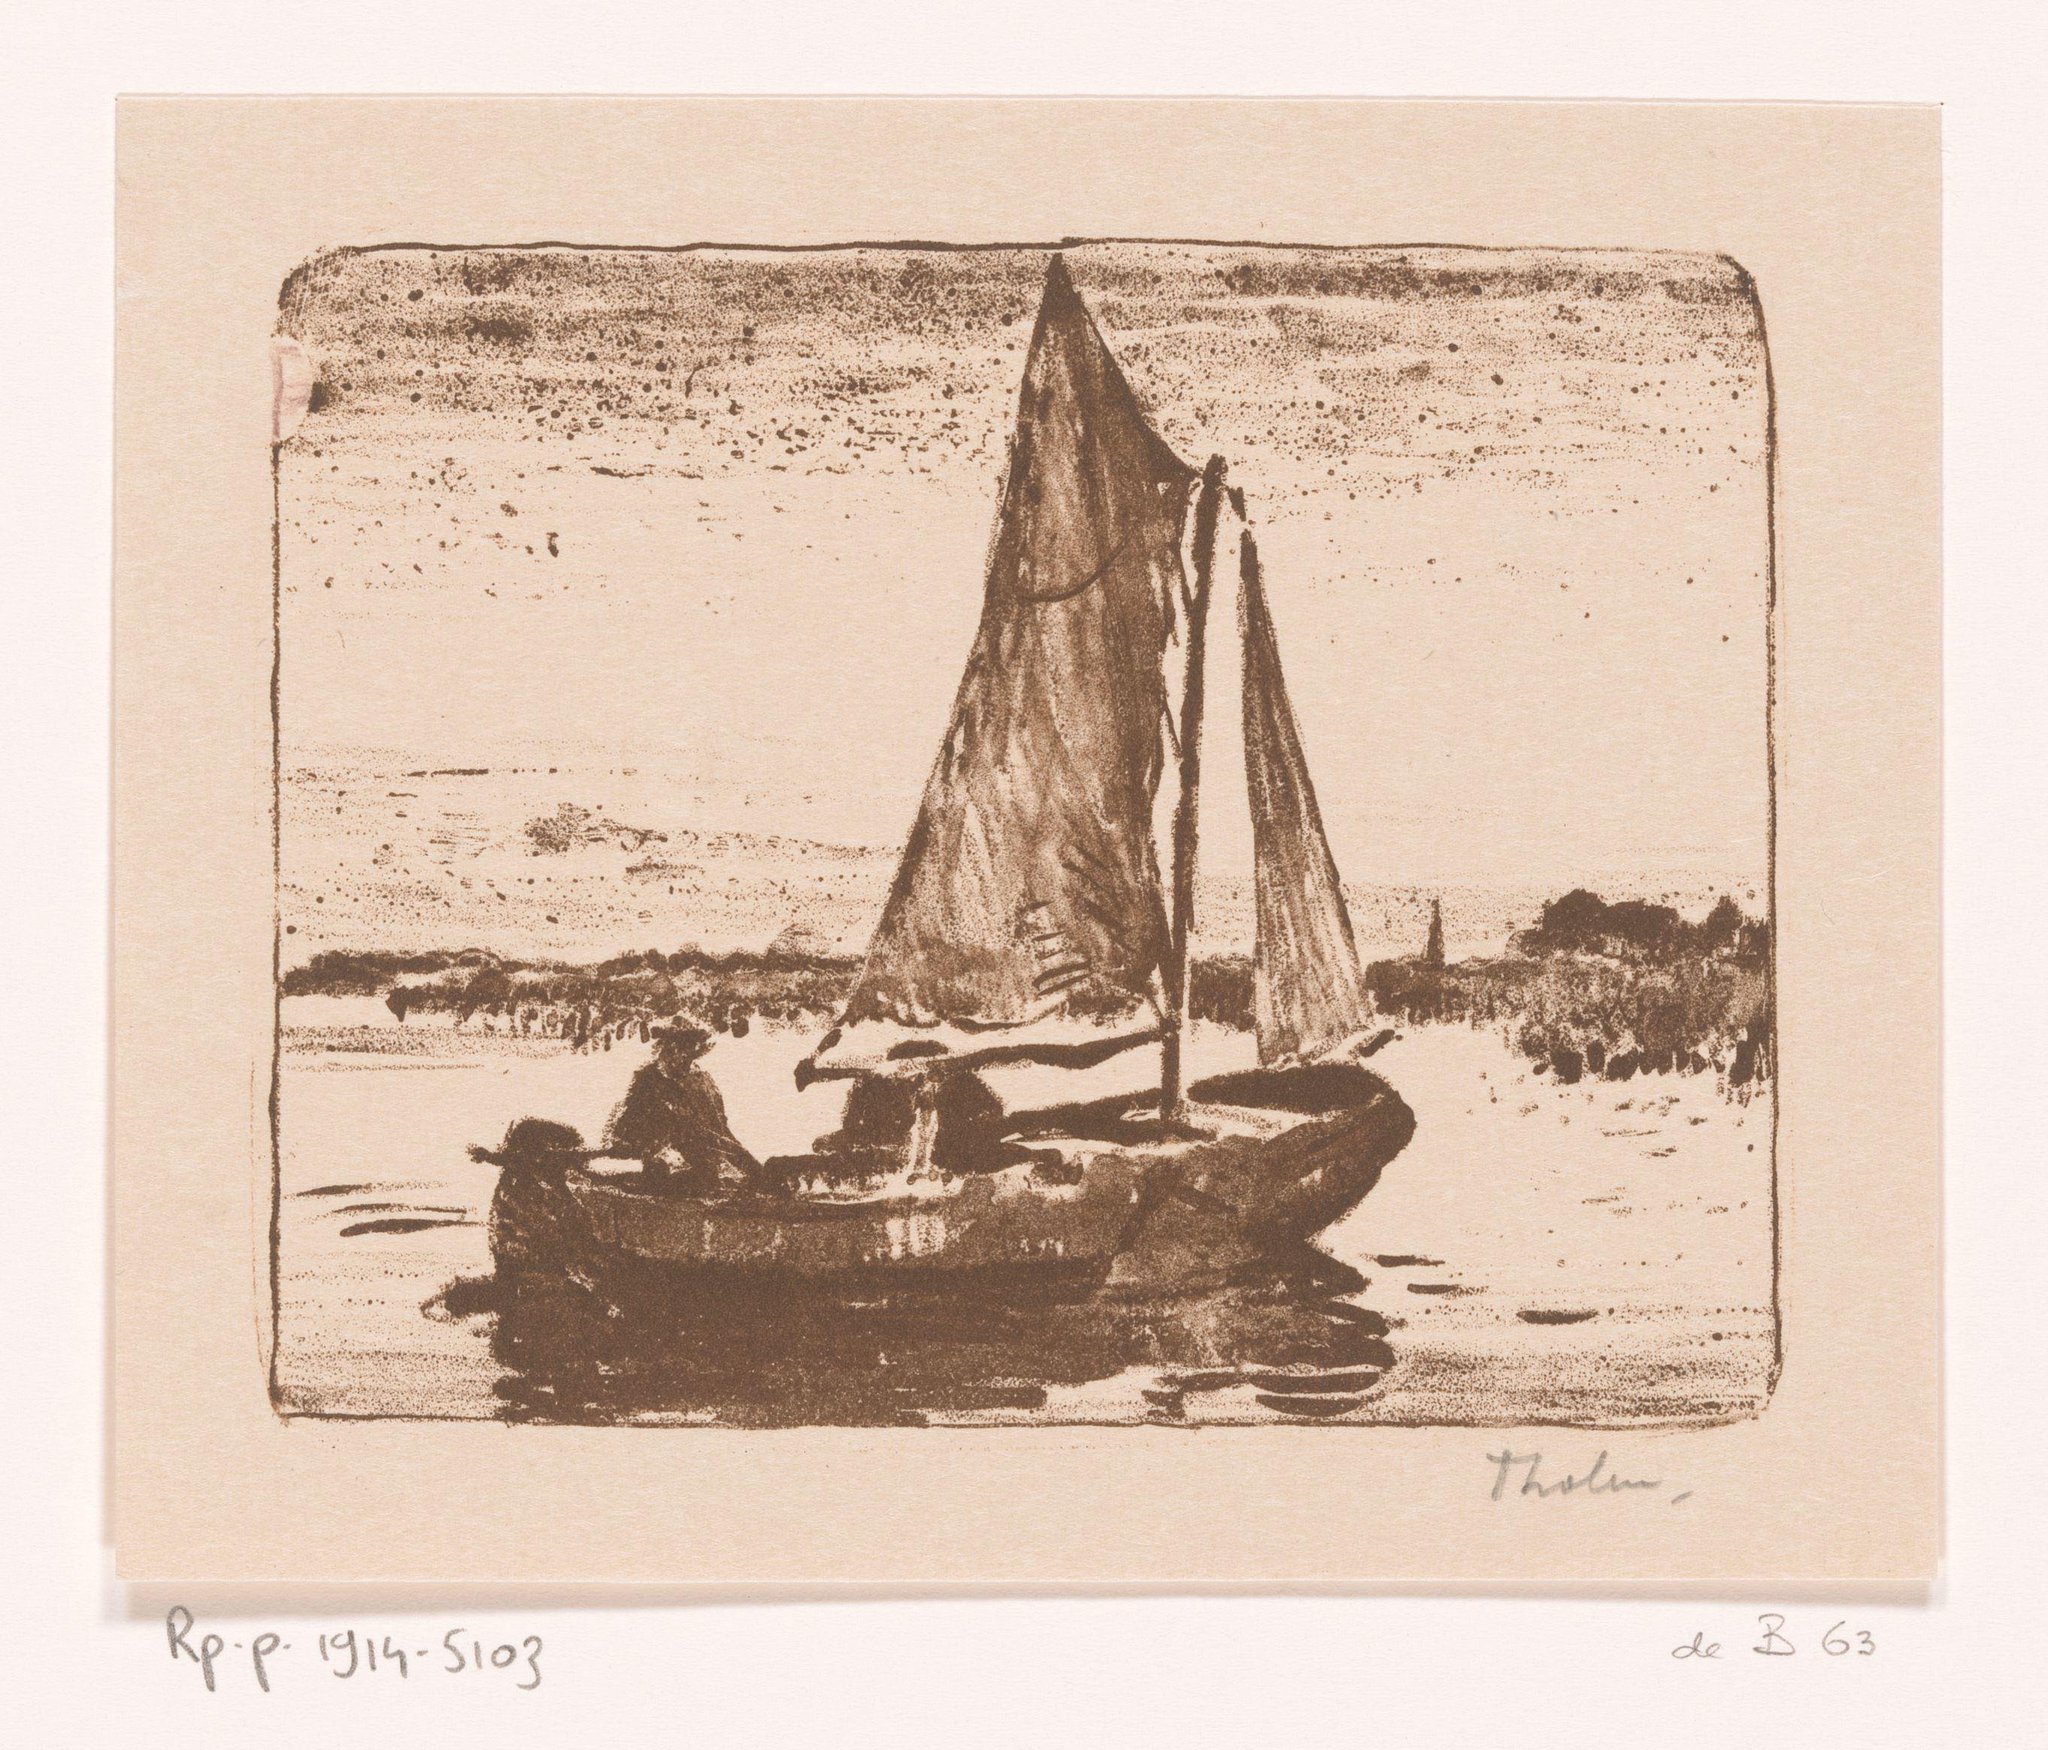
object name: print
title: Schuitje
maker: willem bastiaan tholen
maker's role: draughtsman, painter, print maker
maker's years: 1860-1931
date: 1870-1914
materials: paper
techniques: lithograph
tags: sailing-ship, sailing-boat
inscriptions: collector's mark: Lugt 2233